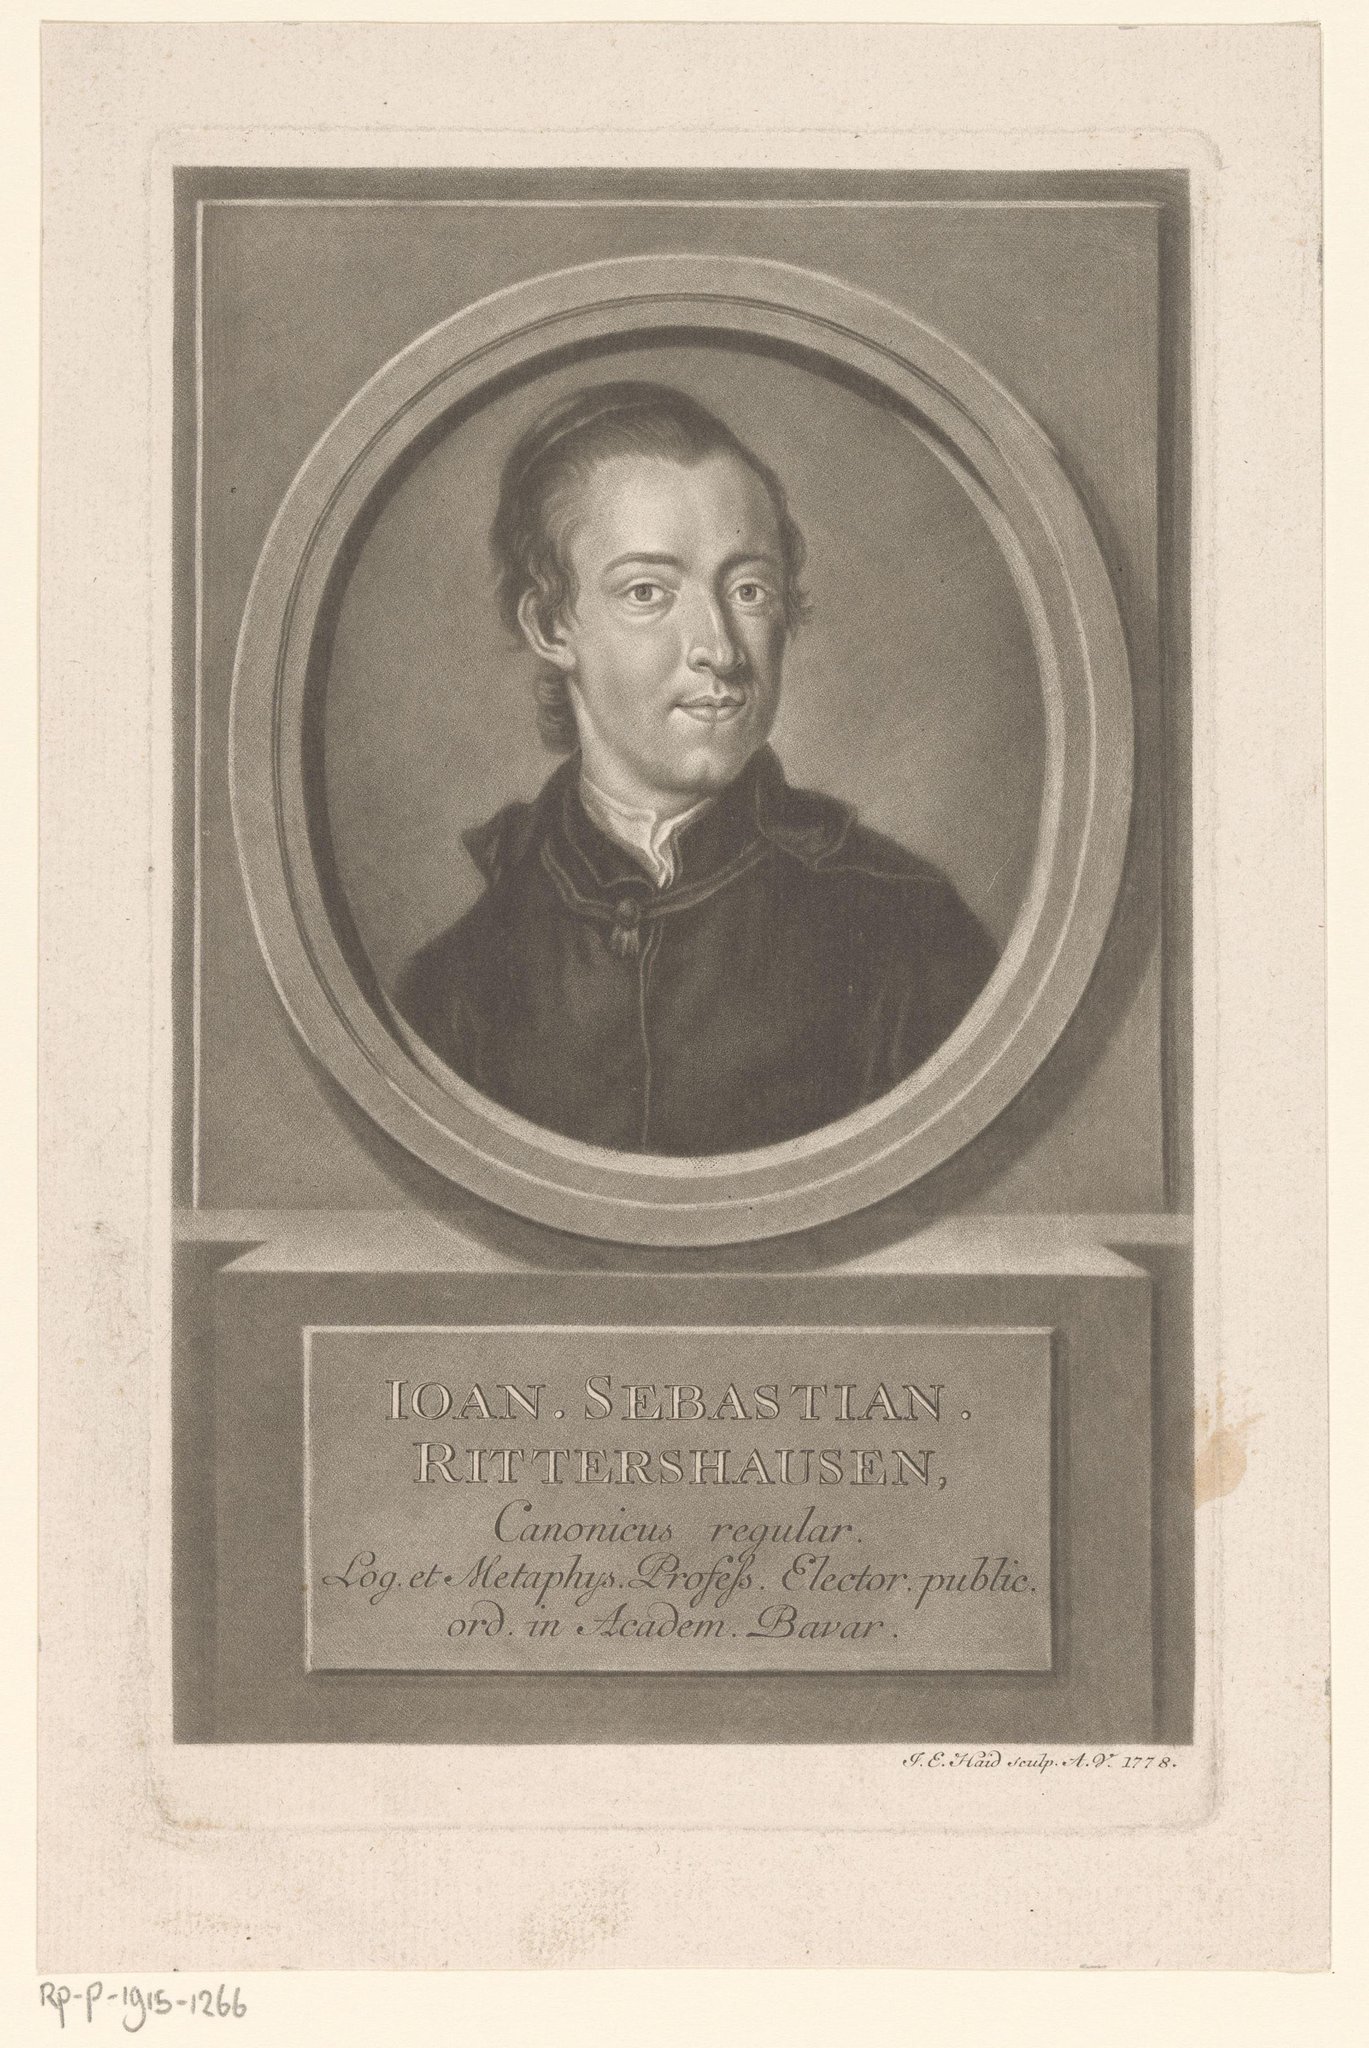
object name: print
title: Portret van Joseph Sebastian von Rittershausen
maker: johann elias haid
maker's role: print maker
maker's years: 1739-1809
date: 1778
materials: paper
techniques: mezzotint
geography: augsburg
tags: painter, historical persons, portrait, self-portrait of painter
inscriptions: collector's mark: Lugt 2228